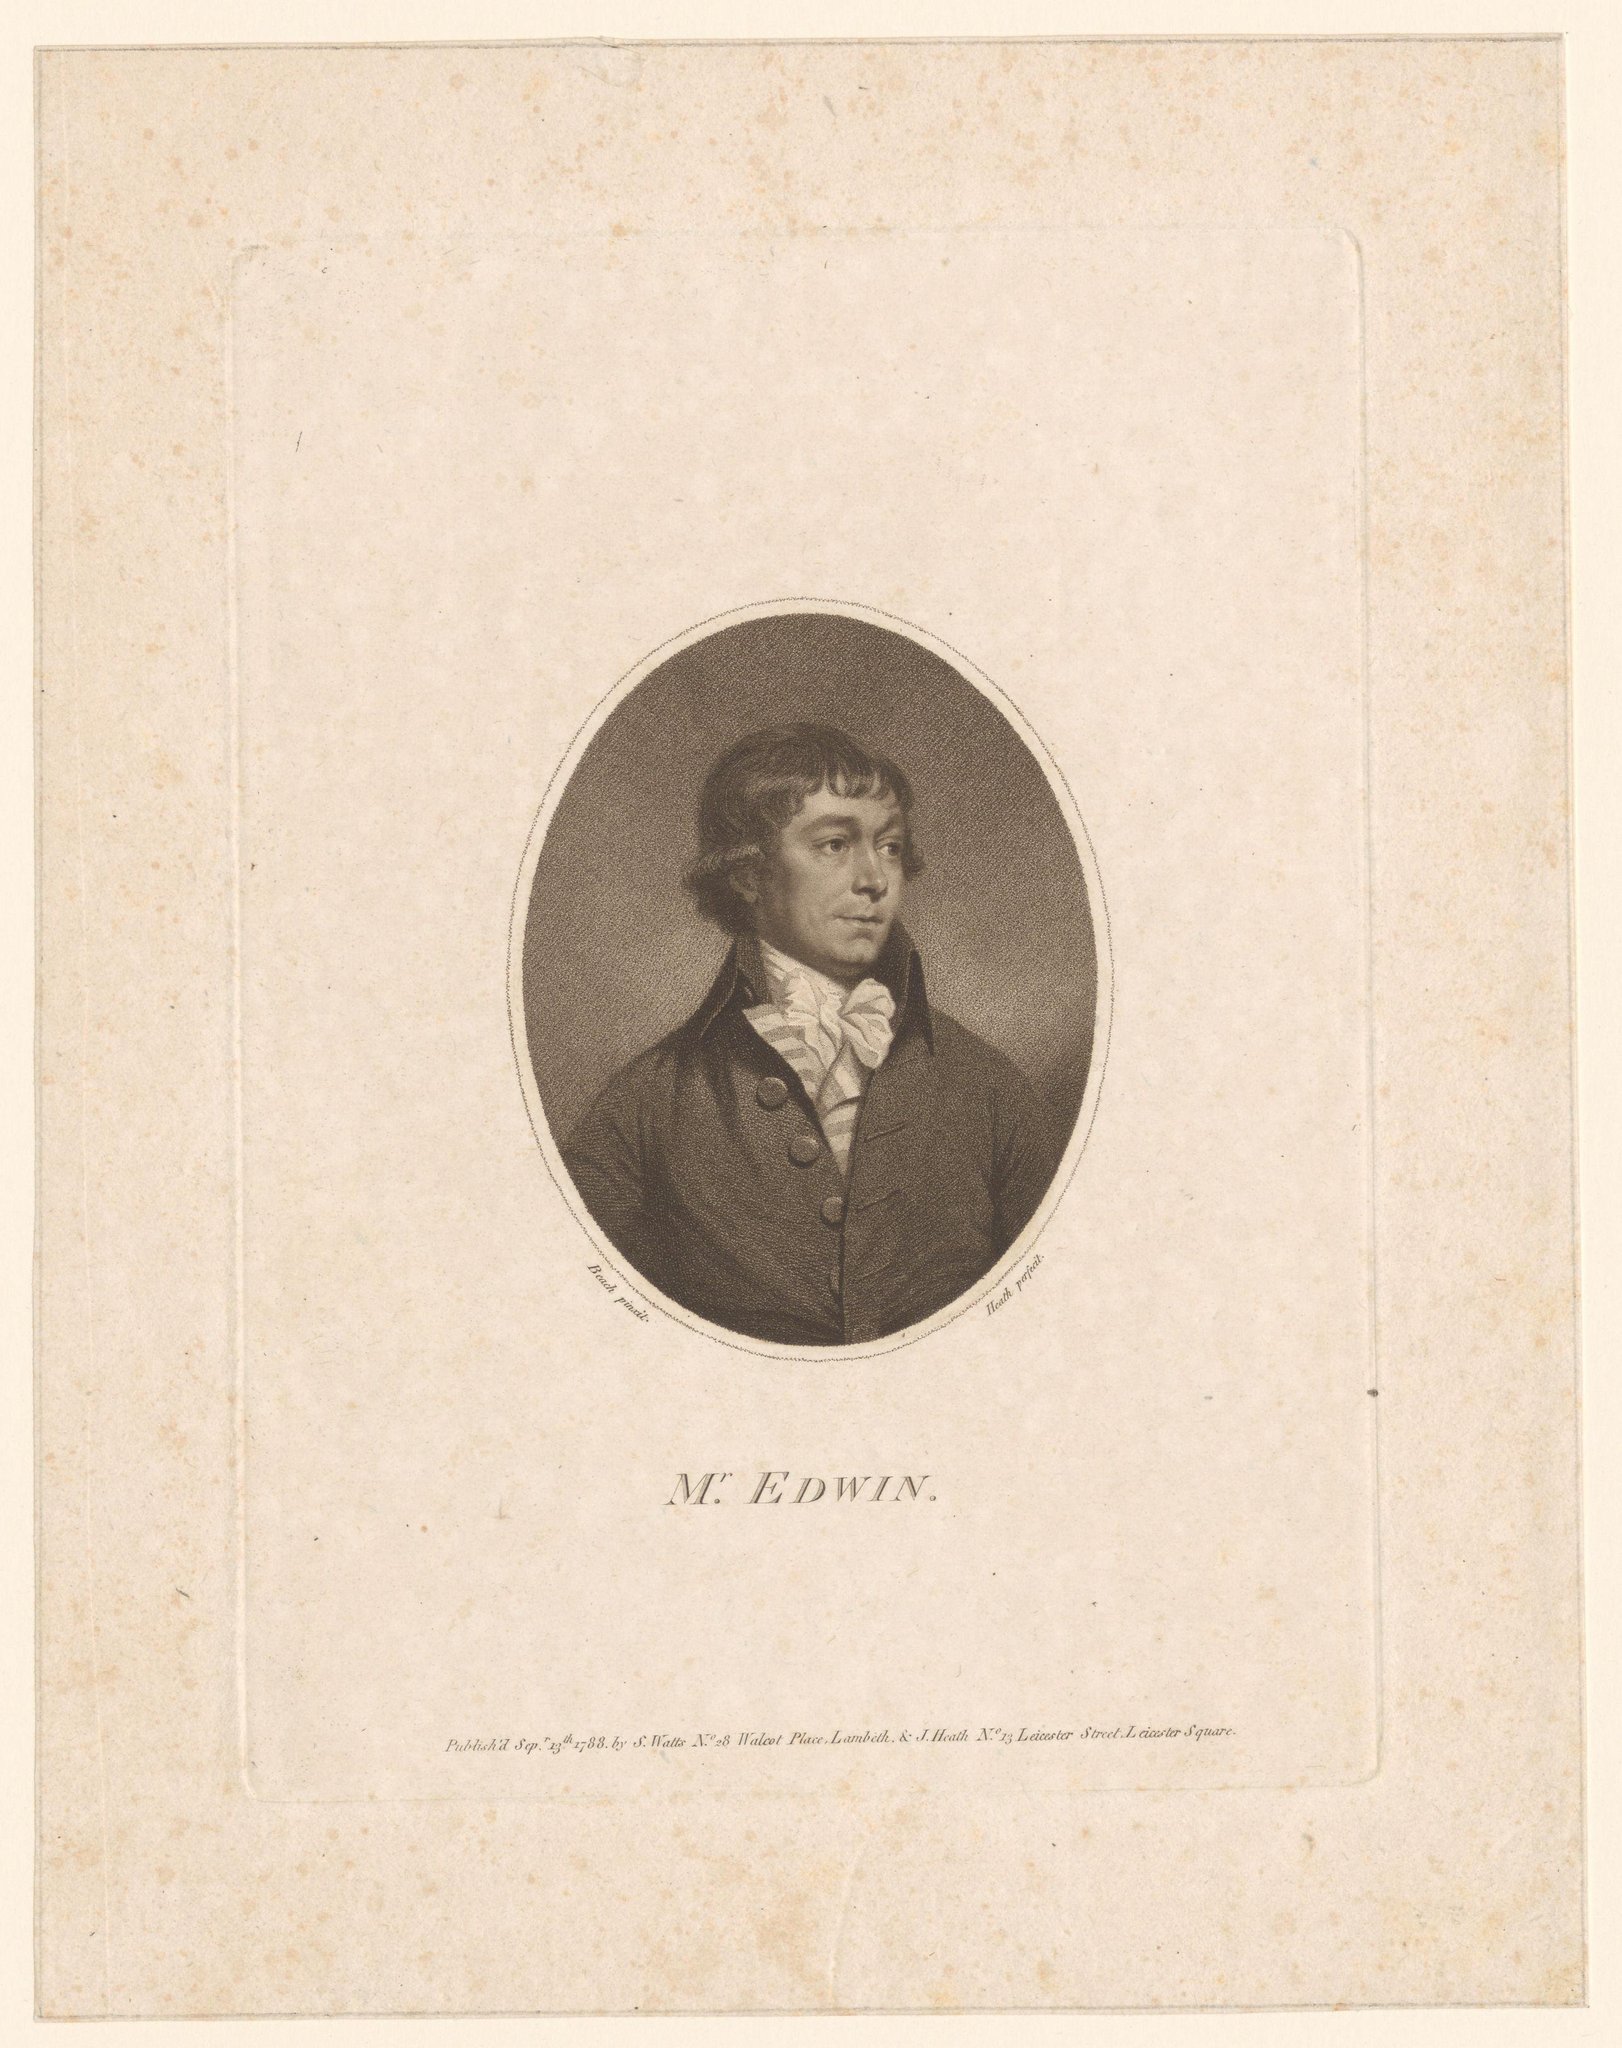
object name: print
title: Mr. Edwin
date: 1709-1788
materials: paper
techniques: etching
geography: london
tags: historical persons, portrait of actor, actress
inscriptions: collector's mark: Lugt 2233